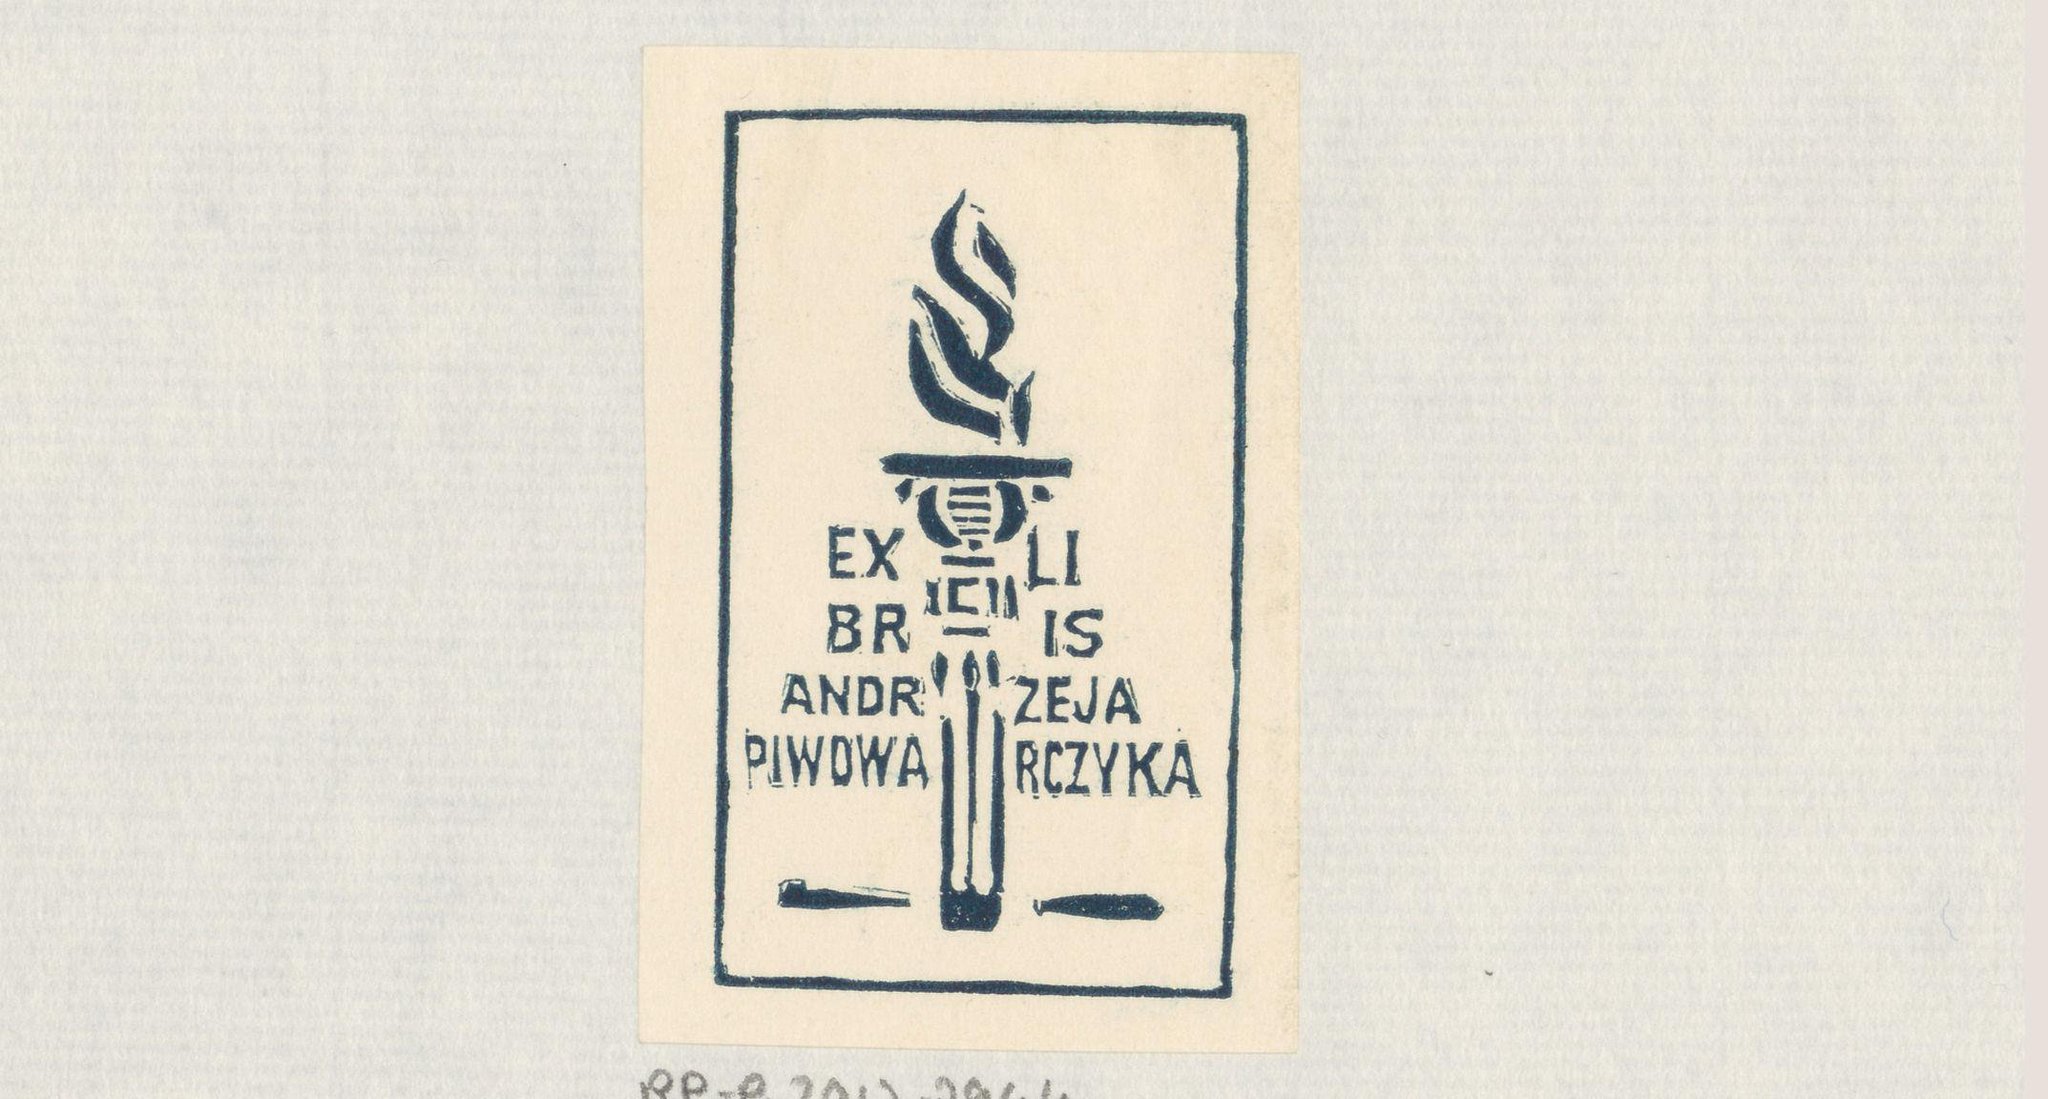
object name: bookplate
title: Ex libris van Andrzej Piwowarczyk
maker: Anonymous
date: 1929-1994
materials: paper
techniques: linocut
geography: poland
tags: torch